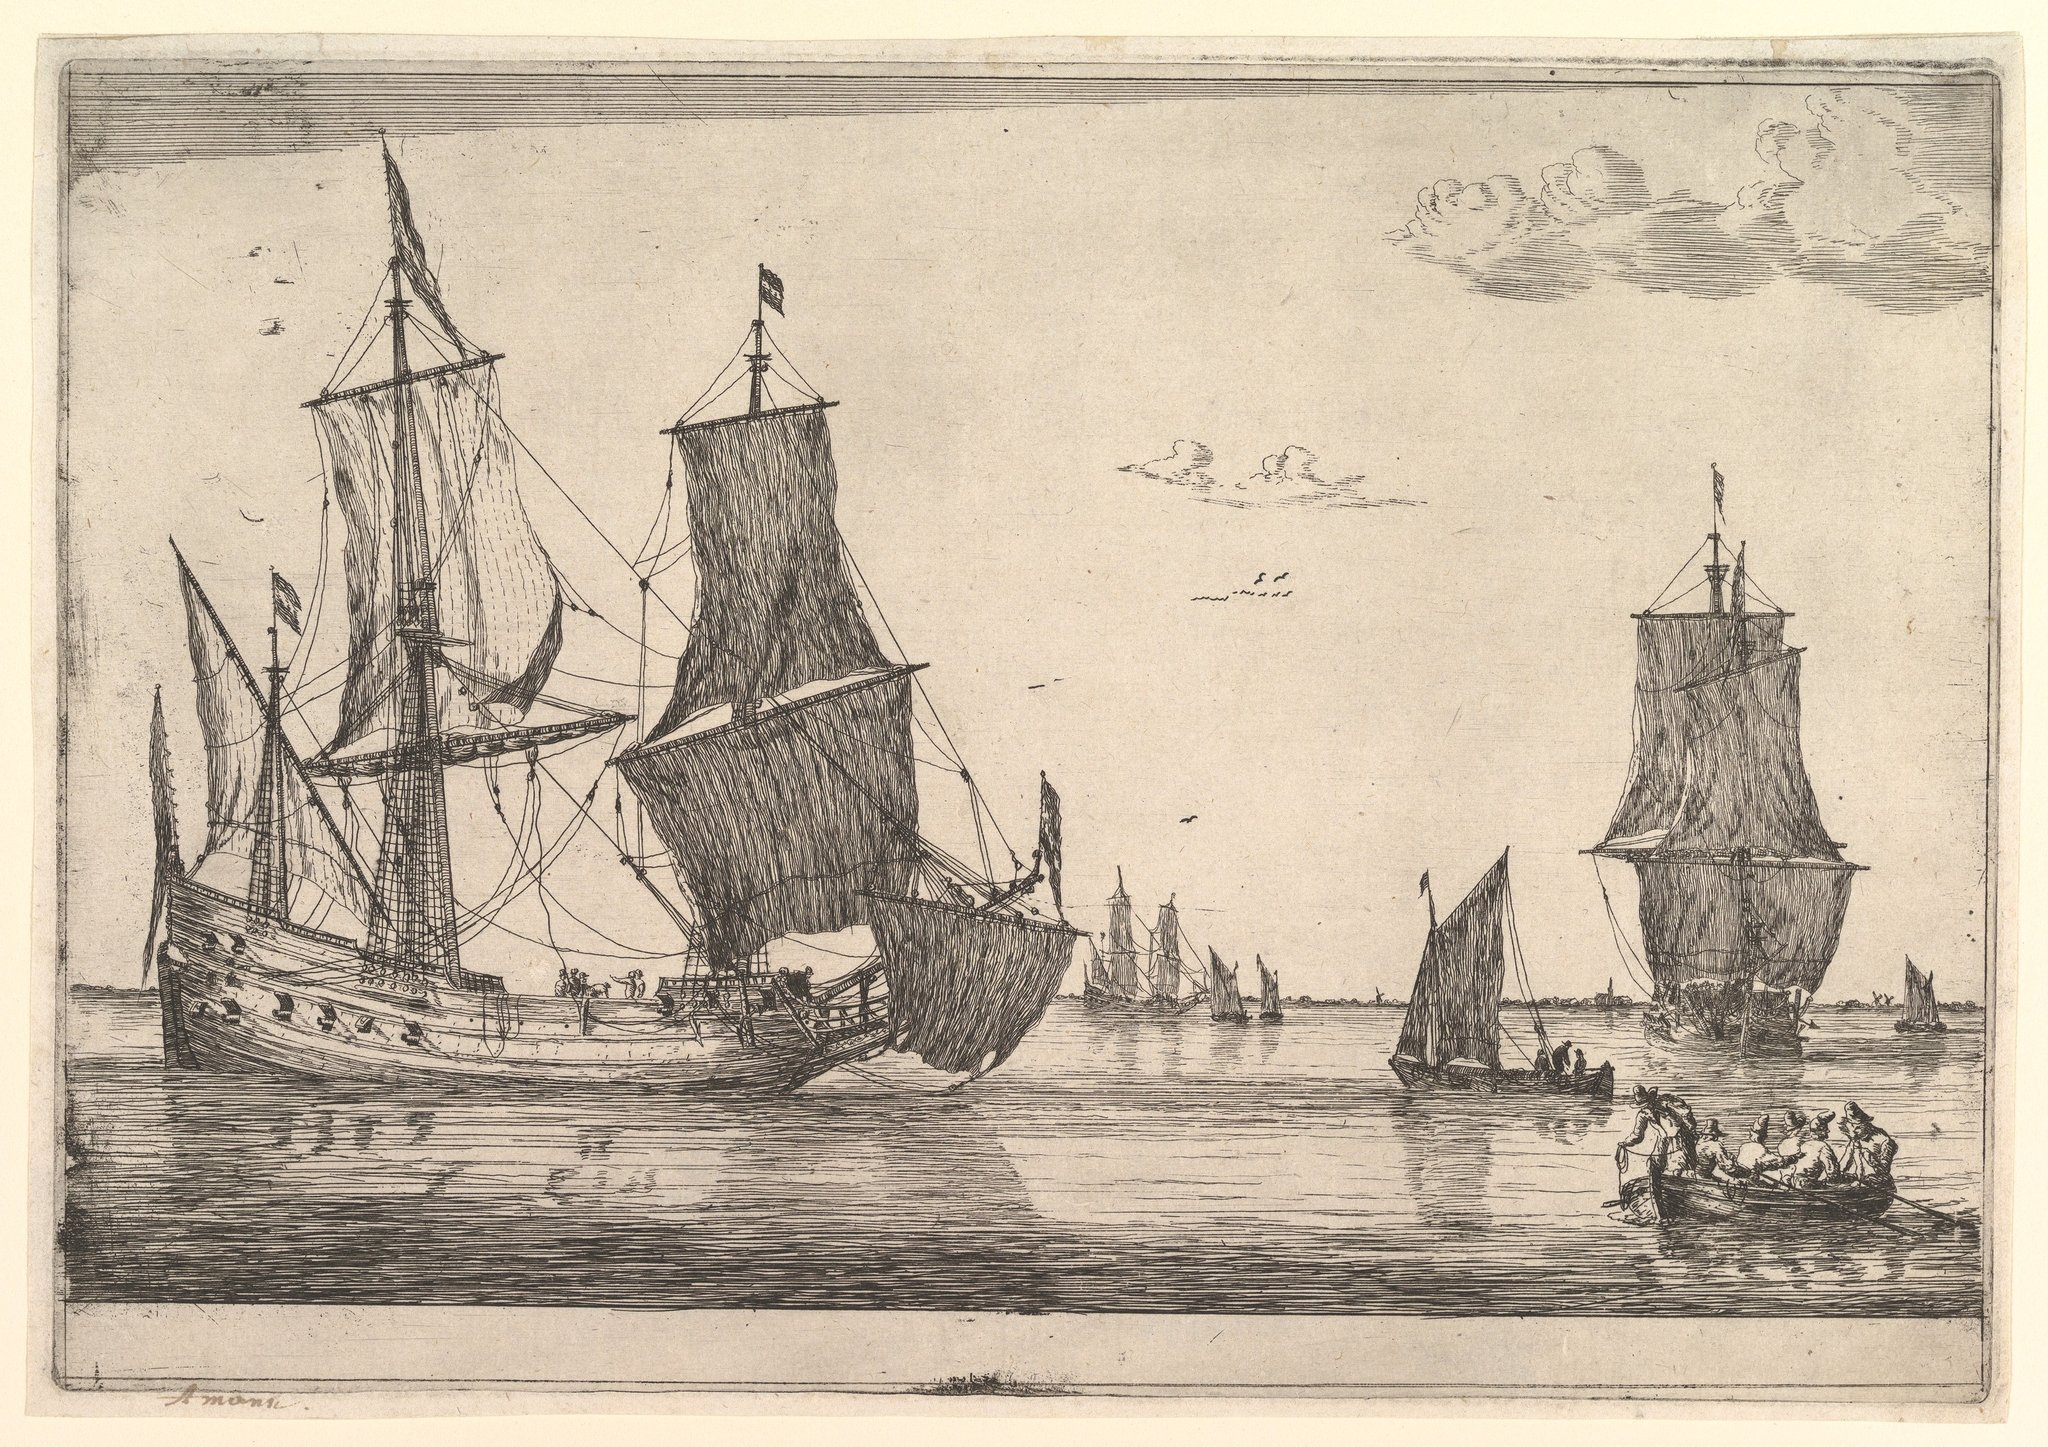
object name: print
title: Large Sailing Vessel and Rowing Boat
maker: reinier nooms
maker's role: artist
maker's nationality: dutch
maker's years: 1623-1664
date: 1601-1700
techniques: etching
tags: boats,ships